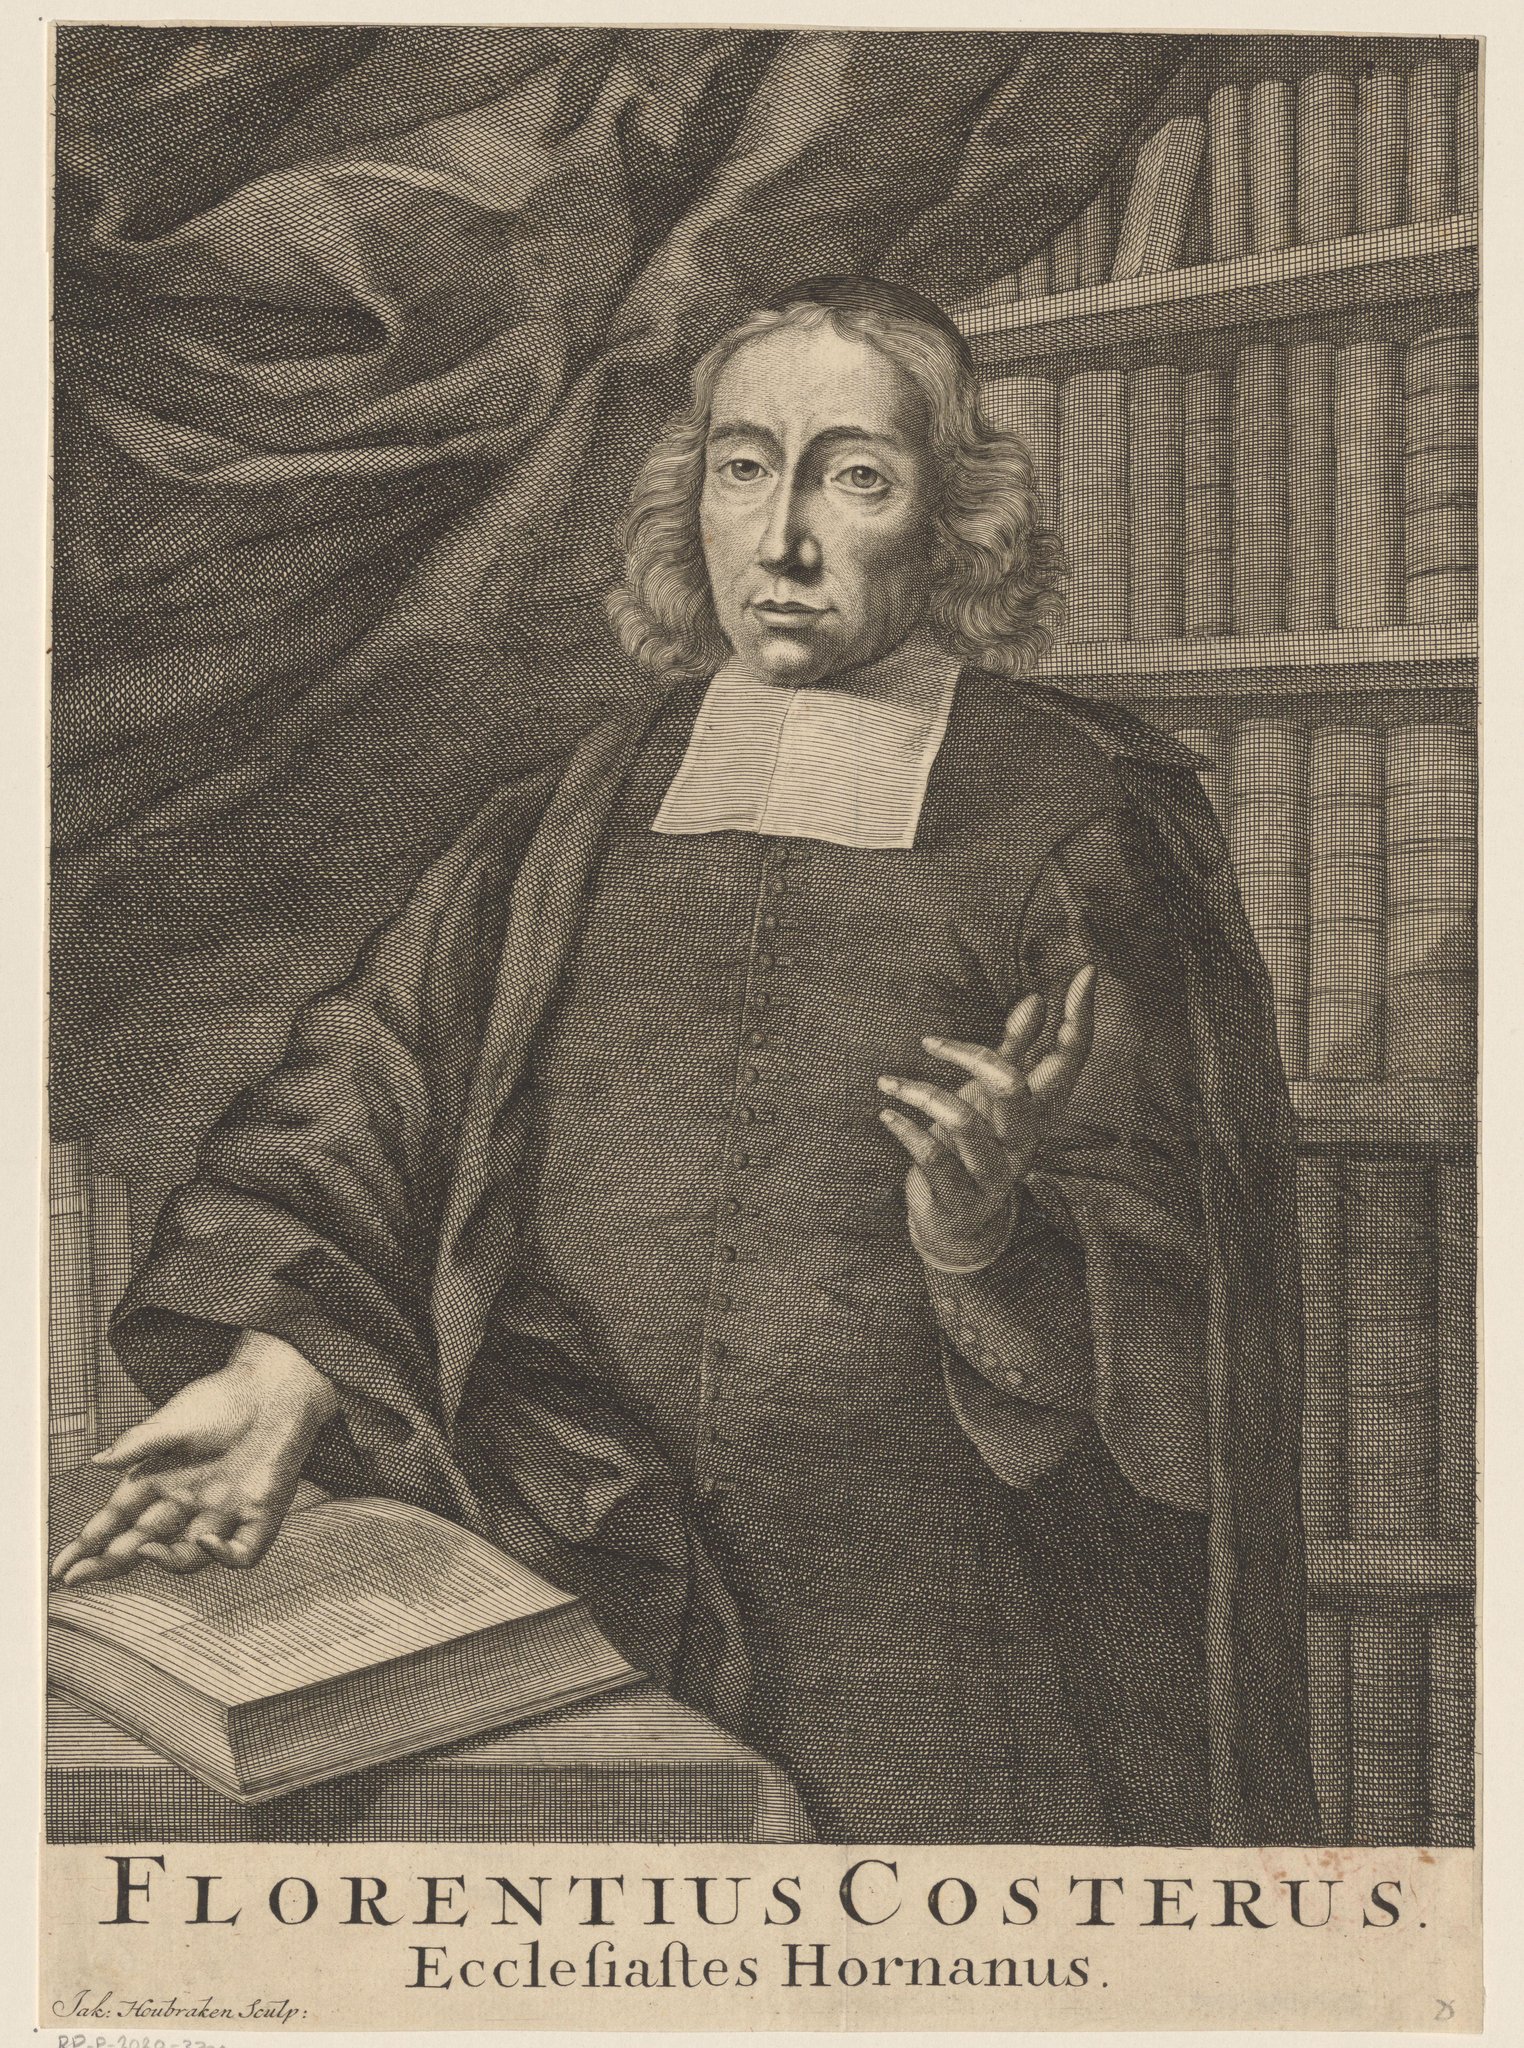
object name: print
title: Portret van Florentius Costerus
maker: jacob houbraken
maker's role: draughtsman, print maker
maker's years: 1698-1780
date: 1710-1780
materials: paper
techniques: engraving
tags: hoorn (north holland), historical persons, study; 'studiolo'; library, the bible as a book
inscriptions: watermark, collector's mark: Lugt 240